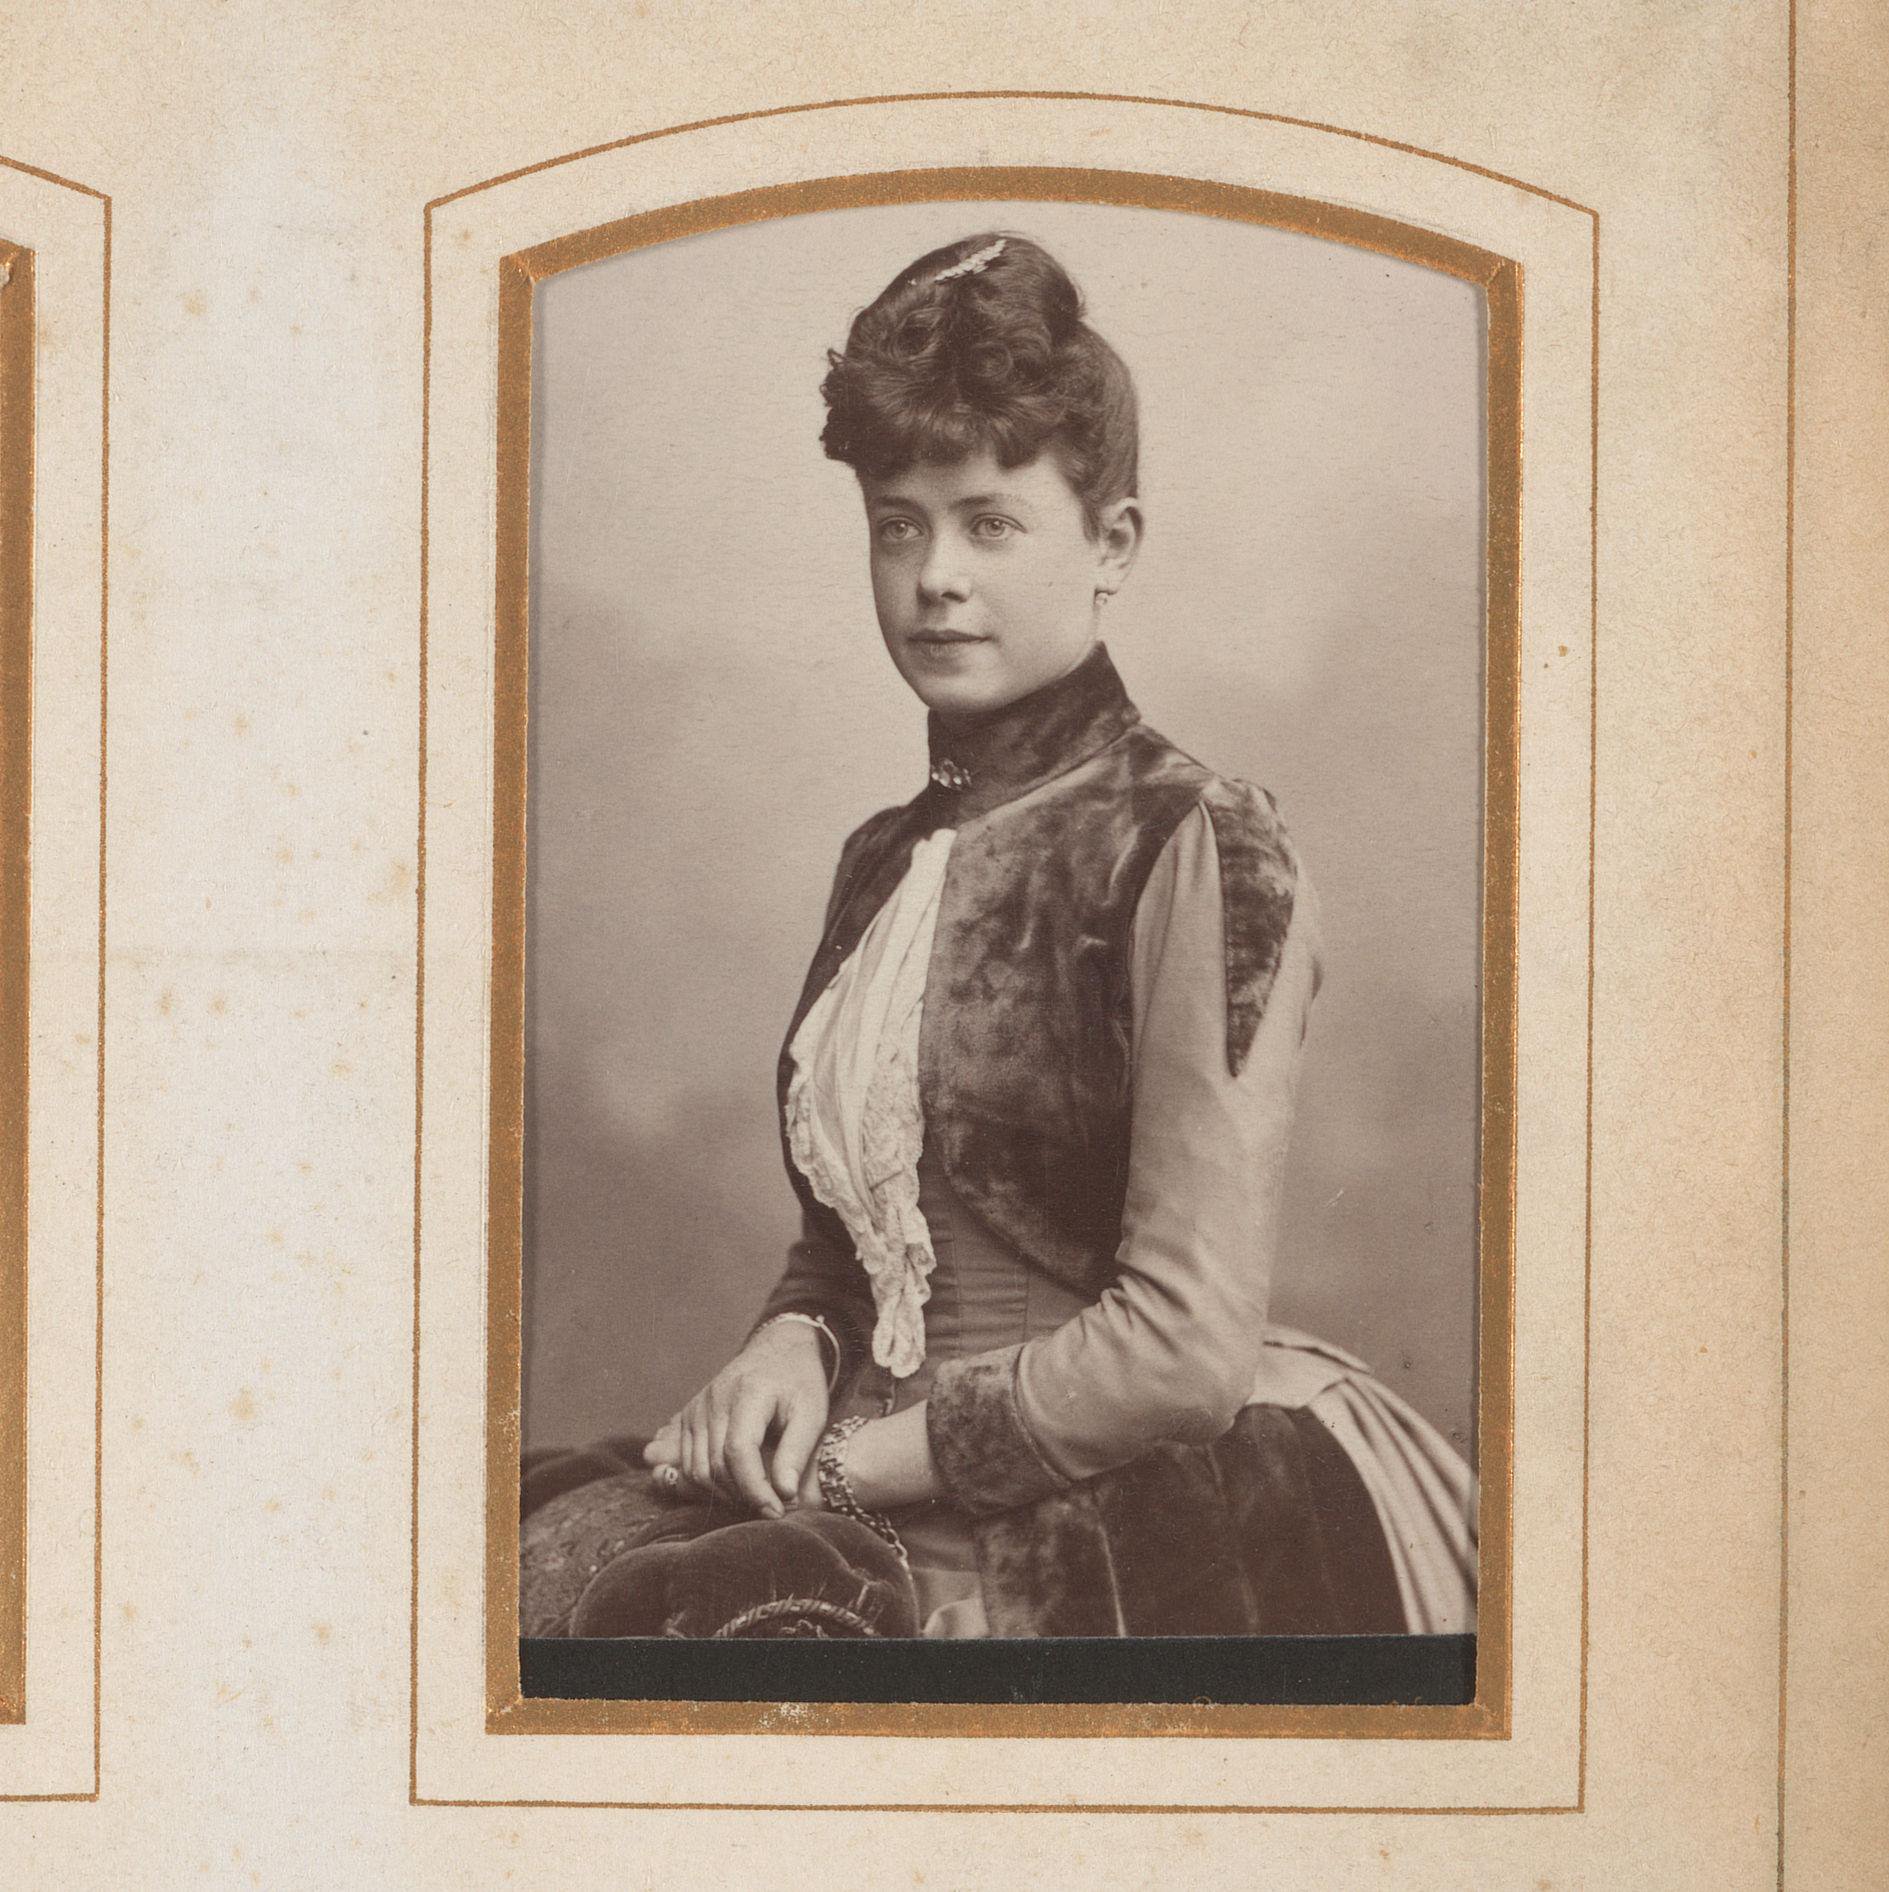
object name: photograph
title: Portret van een staande jonge vrouw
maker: oscar json runstedt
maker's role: fotograaf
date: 1860-1900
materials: cardboard, photographic support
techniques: albumen print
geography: stockholm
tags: adolescent, young woman, maiden, historical persons - bb - woman, standing figure - aa - female human figure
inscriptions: inscription: ‘Oscar Json Runstedt/ Stockholm/ 15 Brunkebergstorg/ Plåten förvaras för efterbeställning.’